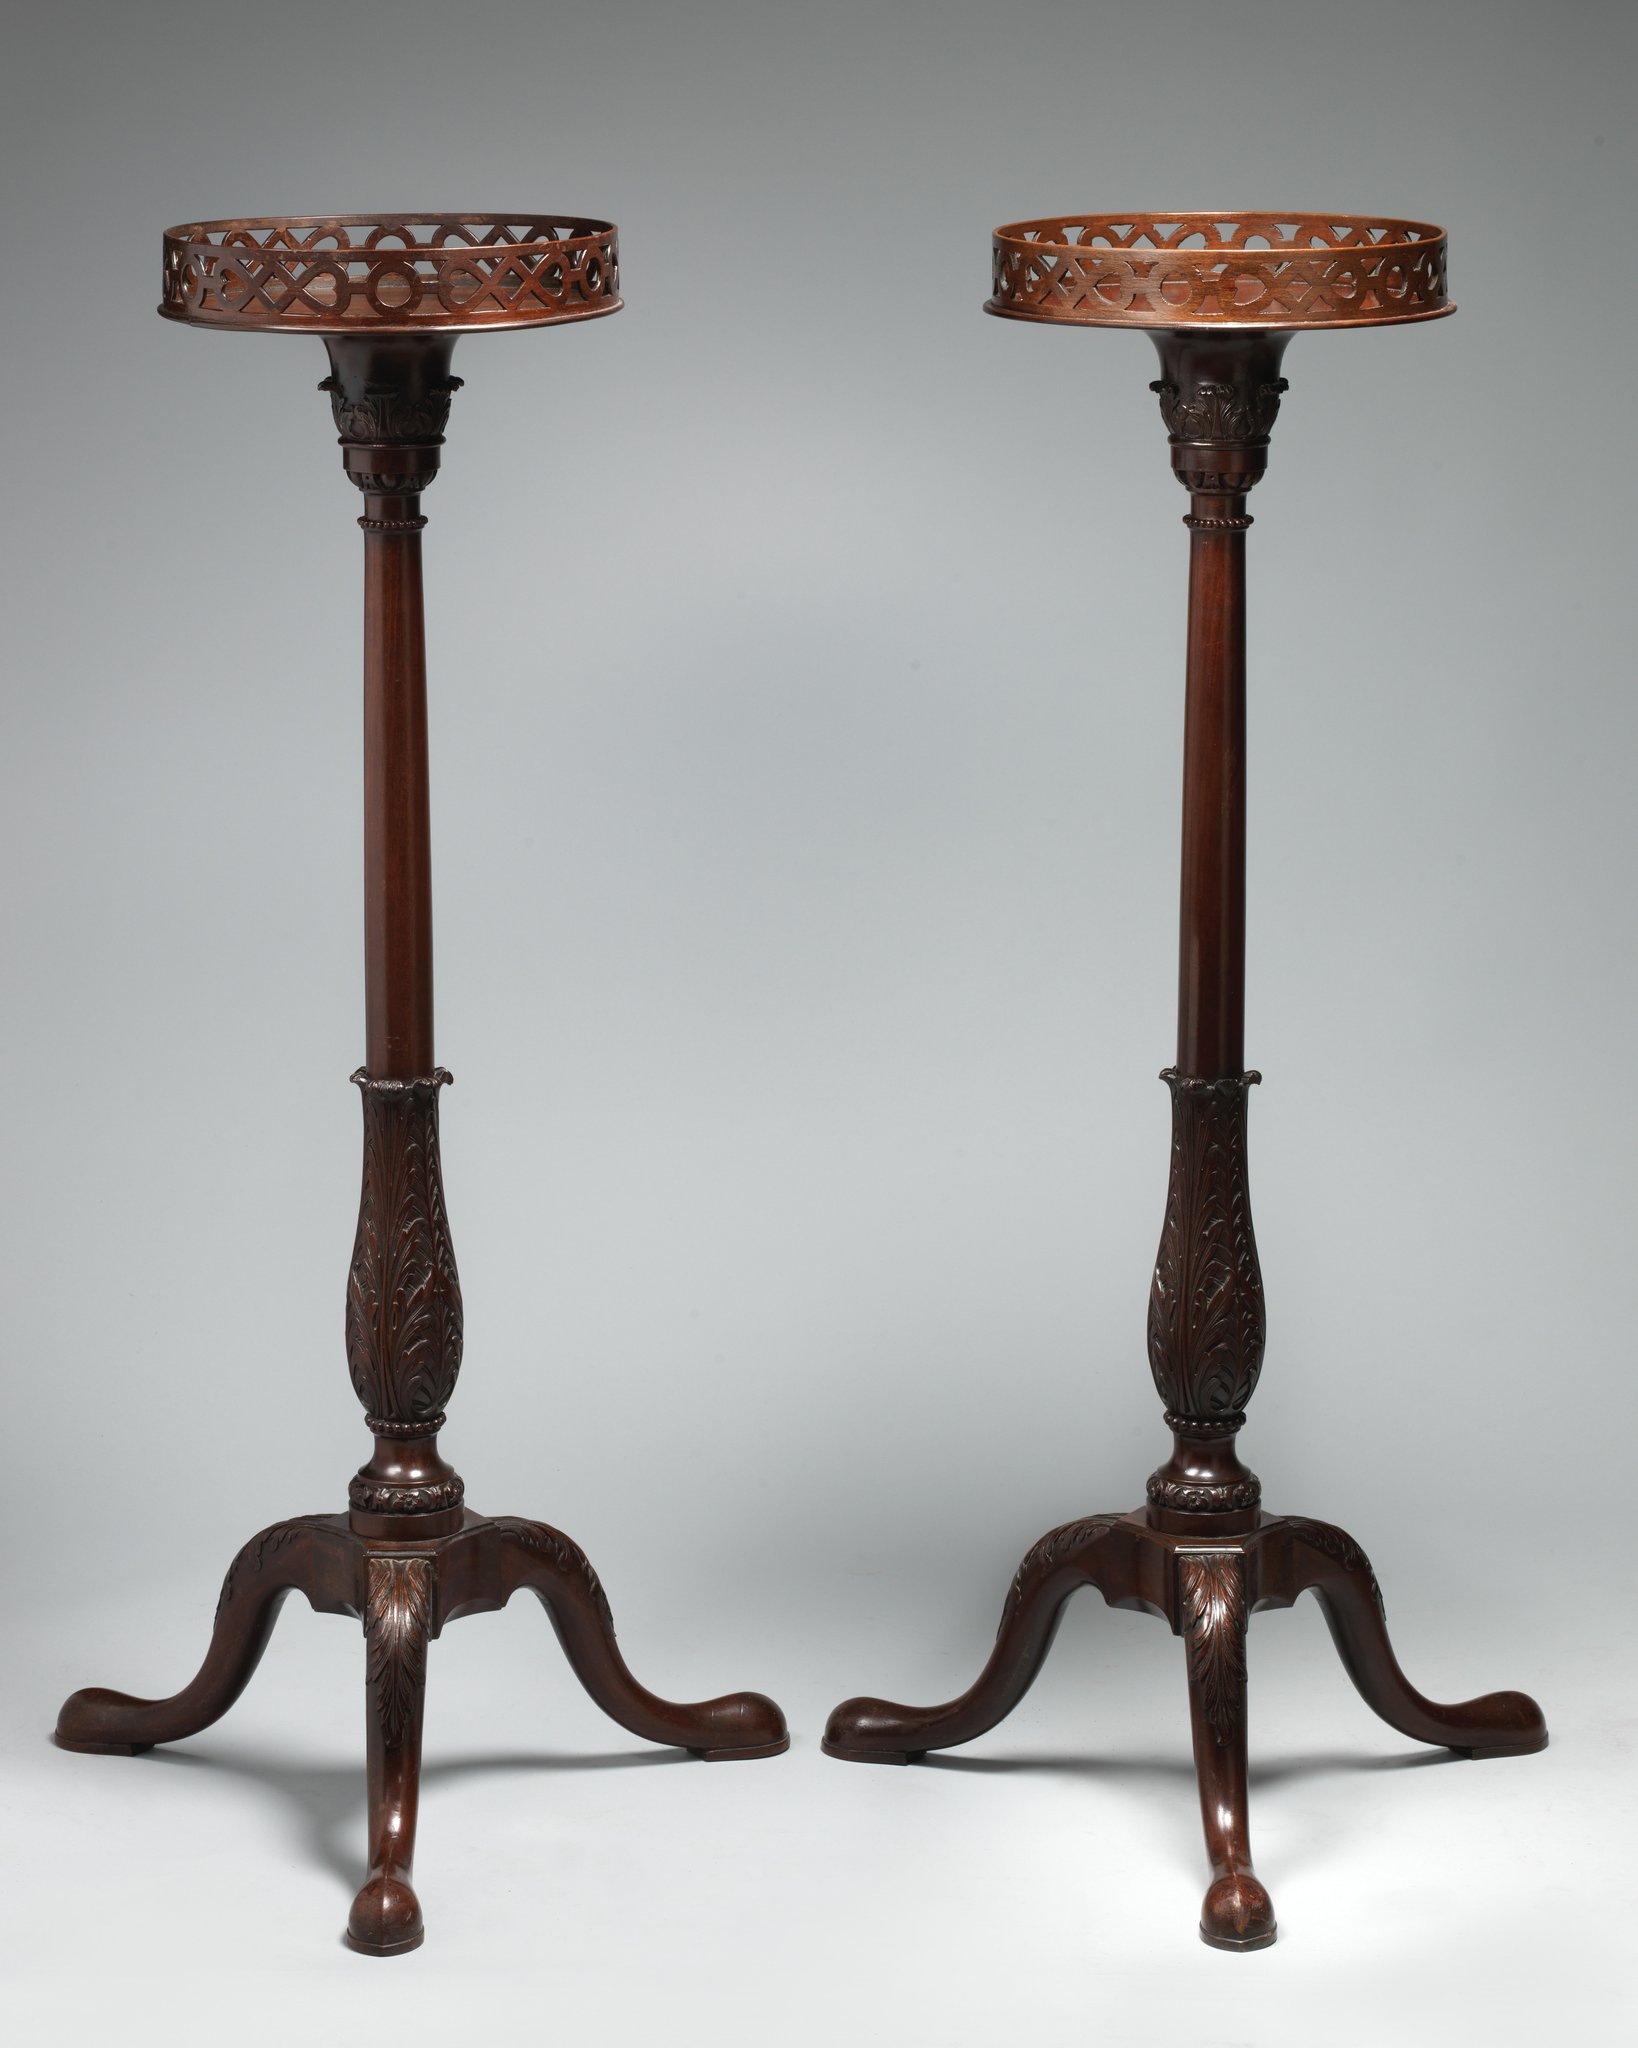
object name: candlestand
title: Pair of candlestands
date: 1735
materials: wood